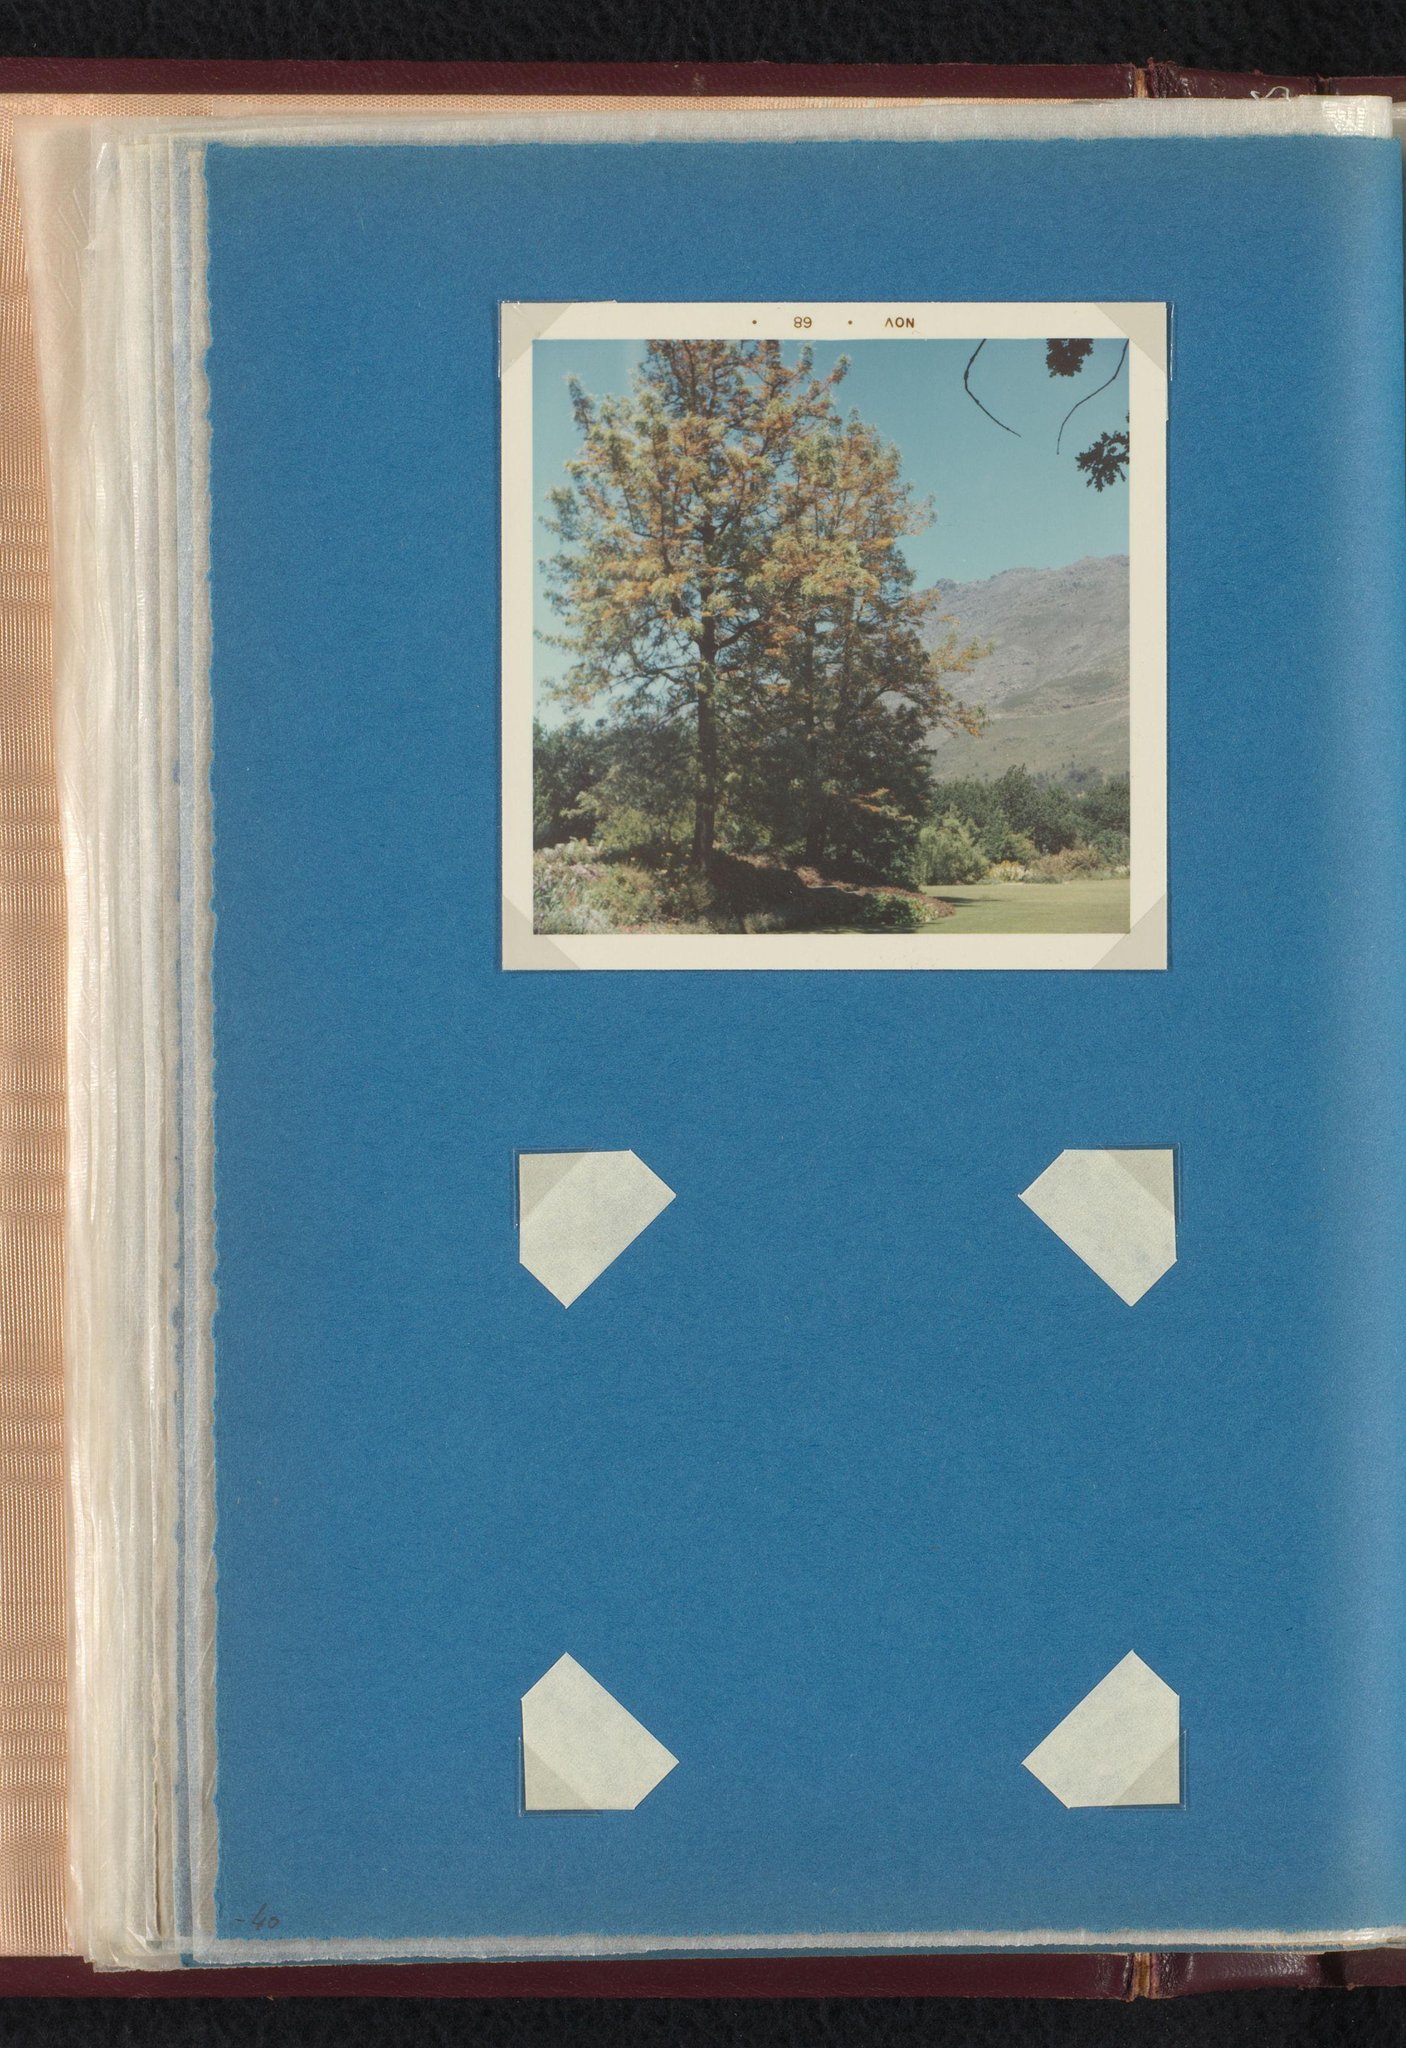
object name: photograph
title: Uitzicht op een tuin, vermoedelijk van wijngaard Lanzerac in Stellenbosch, Zuid-Afrika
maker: willem jacob van den berg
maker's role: boer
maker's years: 1902-1983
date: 1911-1968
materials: paper, cardboard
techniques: chromogenic print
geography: stellenbosch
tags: garden